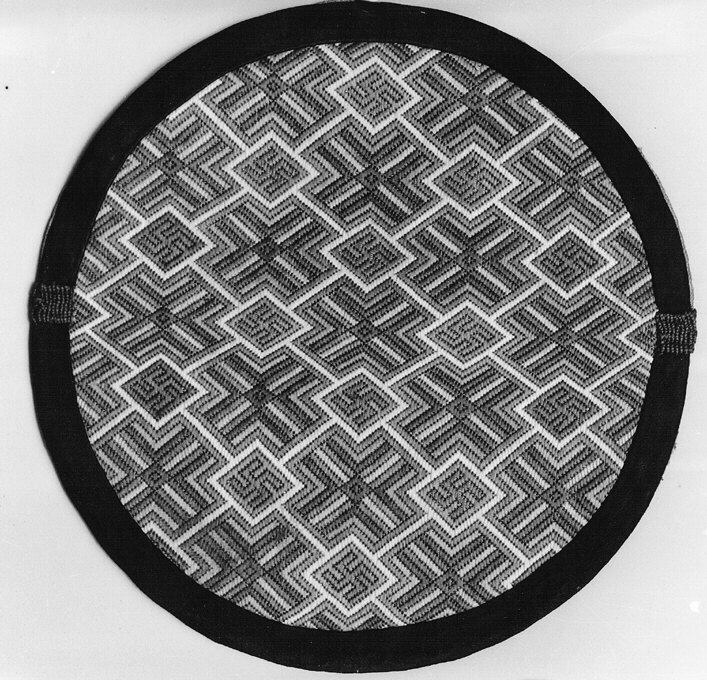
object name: mirror case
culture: chinese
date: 1644-1911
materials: silk